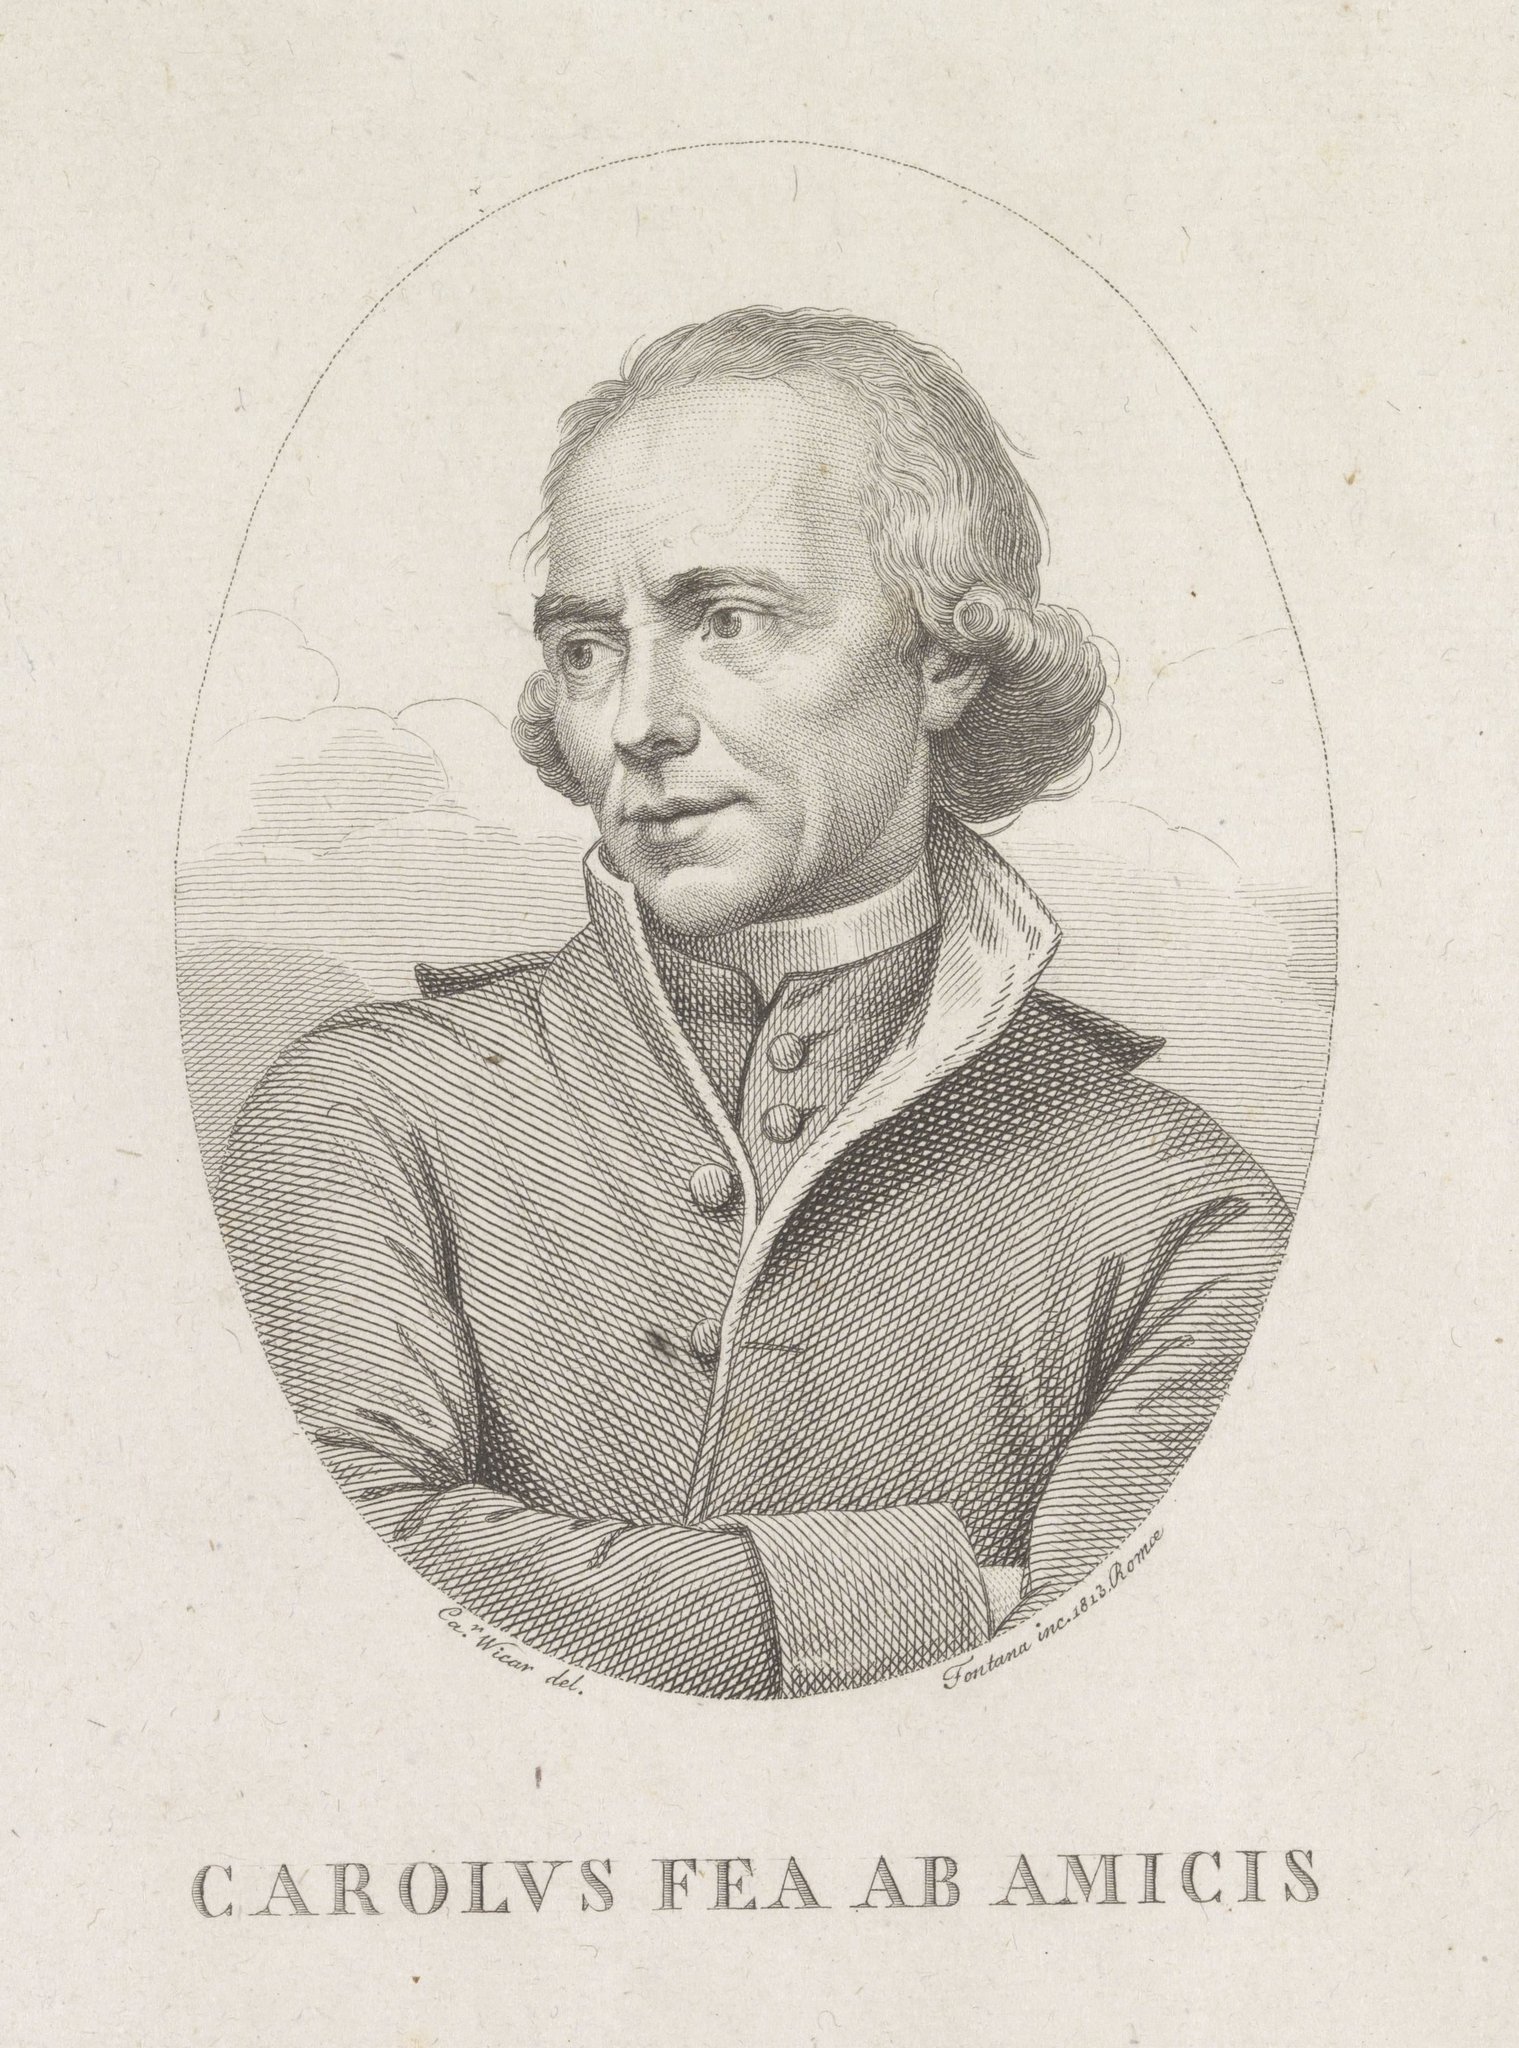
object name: print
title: Portret van archeoloog Carlo Fea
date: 1813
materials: paper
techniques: engraving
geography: rome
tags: rome, historical persons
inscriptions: collector's mark: Lugt 2228